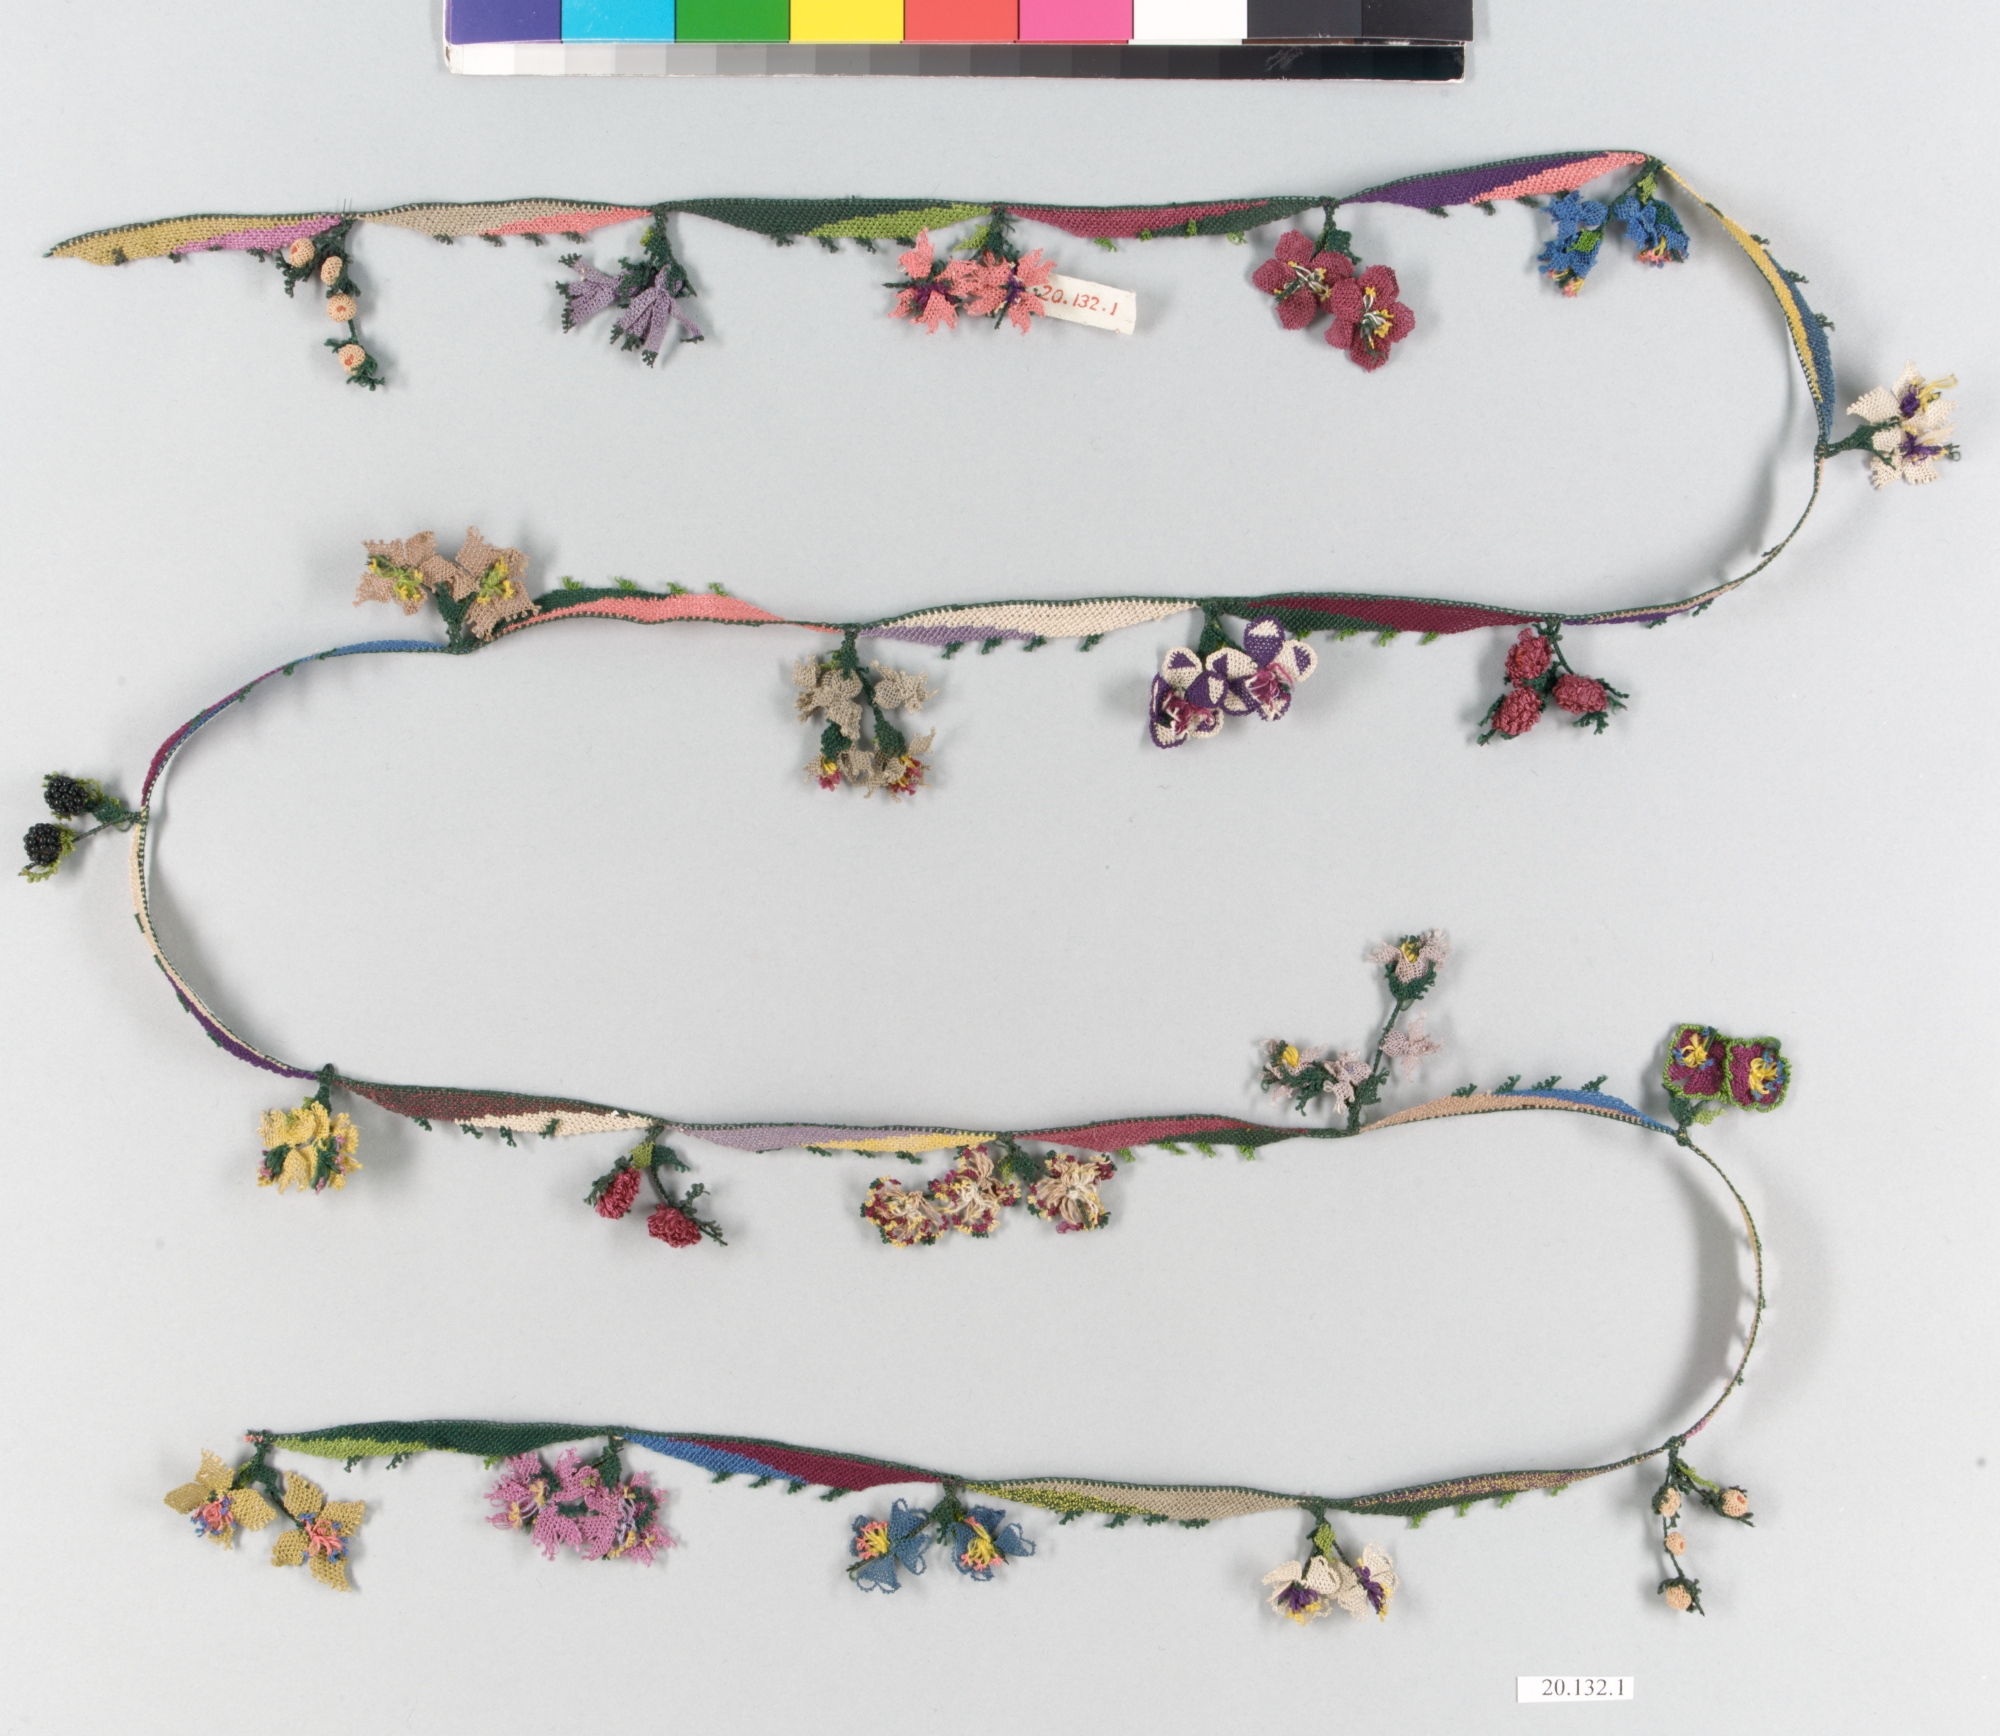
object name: oyah bibilia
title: Oyah (Bibilia)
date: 1801-1900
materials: silk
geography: turkey